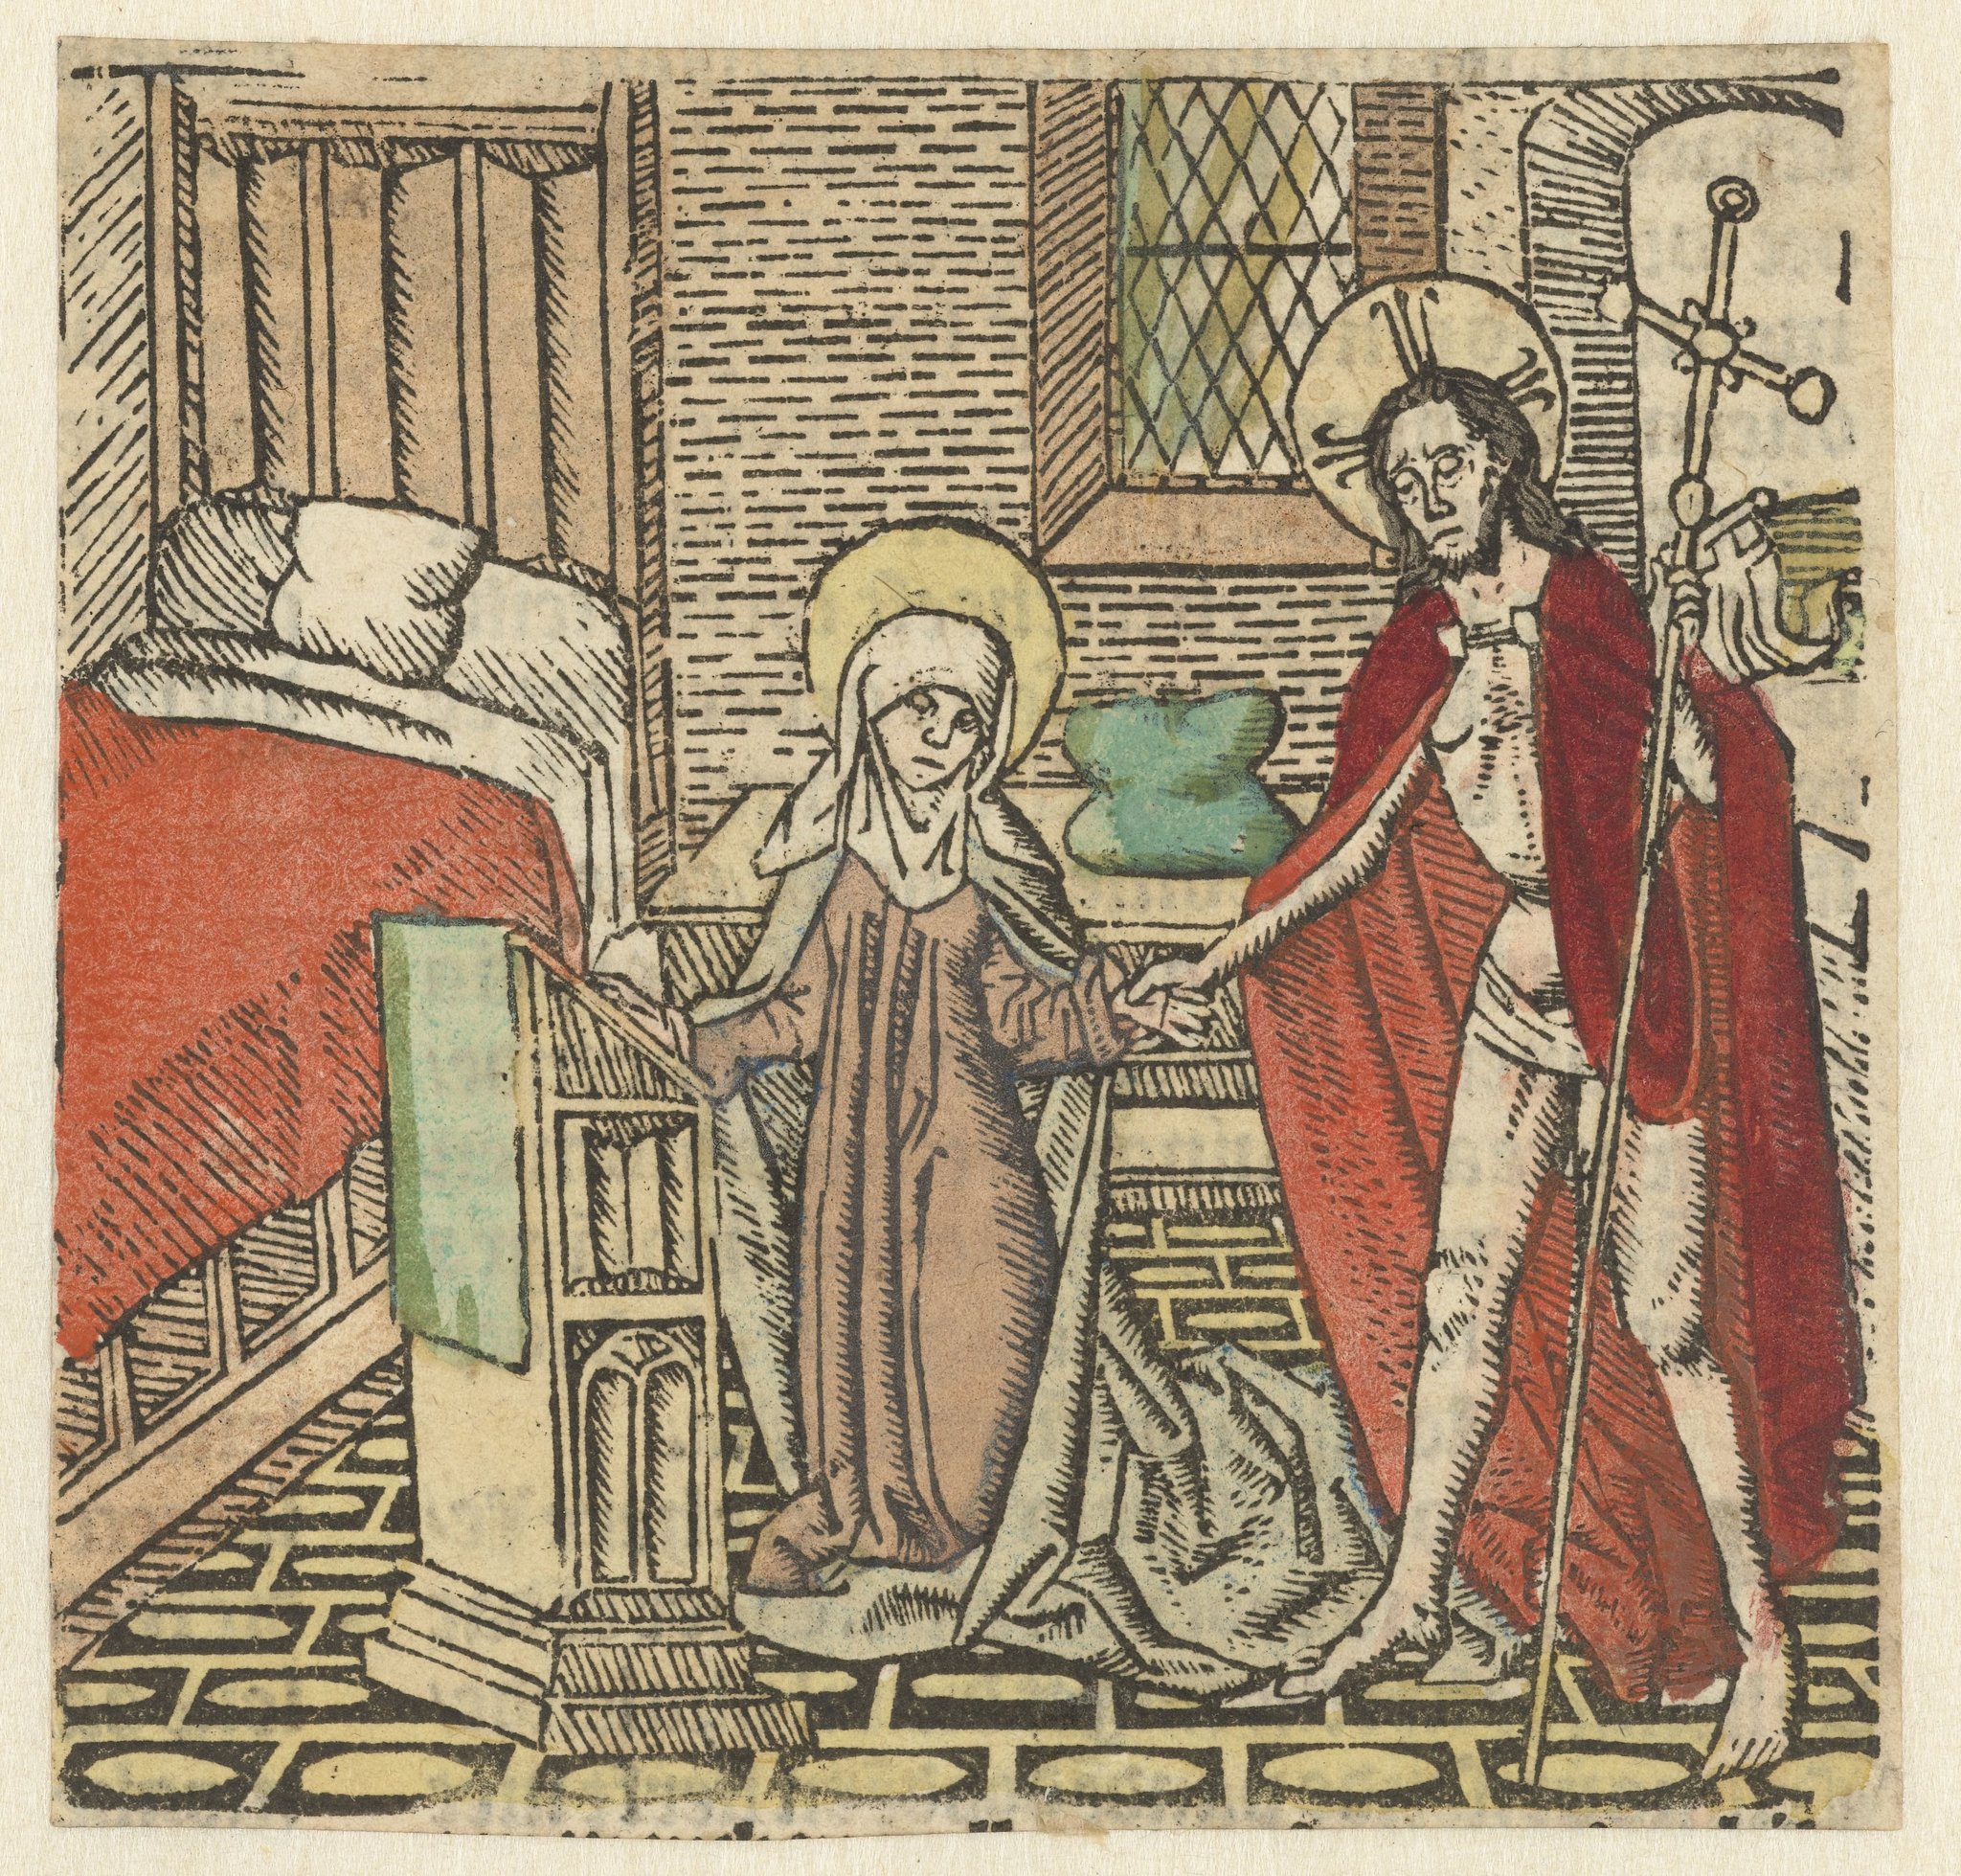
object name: book illustration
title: Christus verschijnt aan Maria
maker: the haarlem woodcutter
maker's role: print maker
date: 1485-1491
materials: paper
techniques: hand coloring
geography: low countries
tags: christ, perhaps dressed as a pilgrim, appearing to his mother, who is usually shown praying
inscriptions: collector's mark: Lugt 2228a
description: Eén van 46 houtsnedes uit Ludolphus de Saxonia "Tboeck vandan leven ons heeren Jesu Christi", een anonieme Nederlandse vertaling. Deze versie van het werk van Ludolphus bevat houtsneden van de Meester van Gouda (II), de Meester van Antwerpen (I) en de Meester van Haarlem. Botke, K. Boek van Ludolphus is voor het eerst uitgegeven in 1487 door Geeraert Leeu te Antwerpen. In 1488 uitgegeven door Claes Leeu te Antwerpen, in 1495 en 1499 en 1519 door Peter van Os te Zwolle en in 1510 door A. van Berghen te Antwerpen. Deze 46 houtsneden komen waarschijnlijk uit een uitgave van Peter van Os. Botke, K. Oorspronkelijke blok voor deze prent was groter. Zie "De gulden passer" (1951), cat.nr. 121